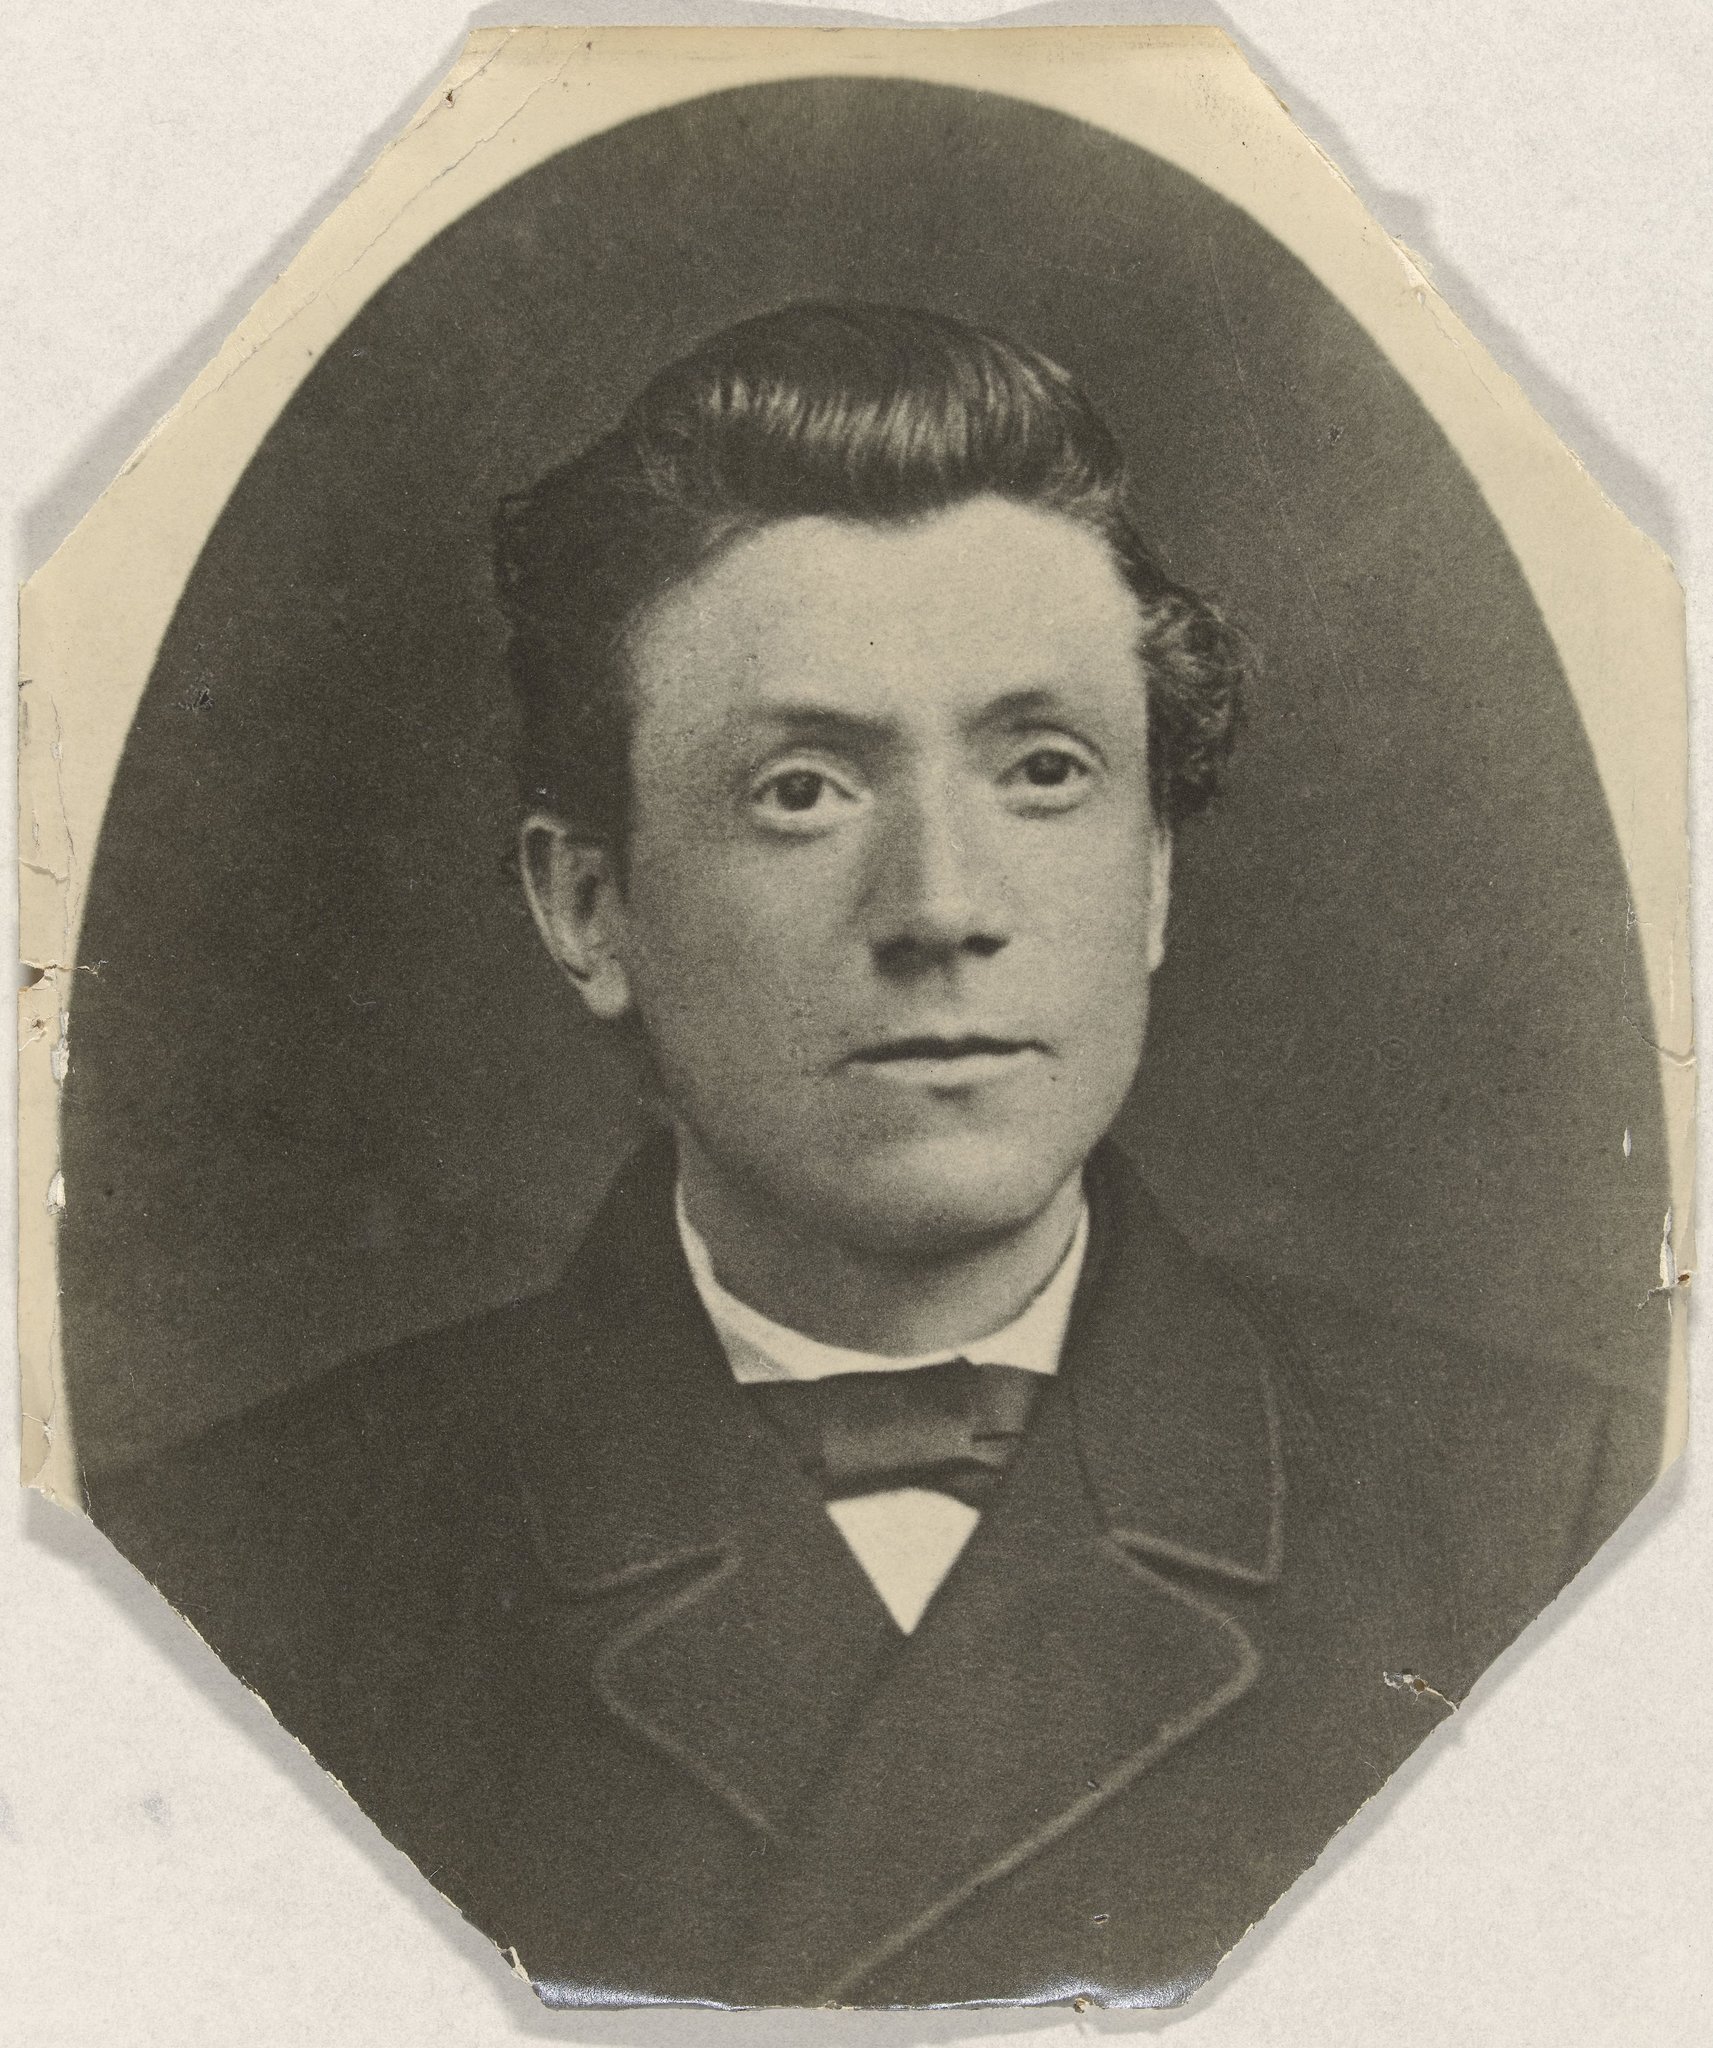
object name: photograph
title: Portret van een man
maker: Anonymous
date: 1890-1910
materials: photographic support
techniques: carbon print